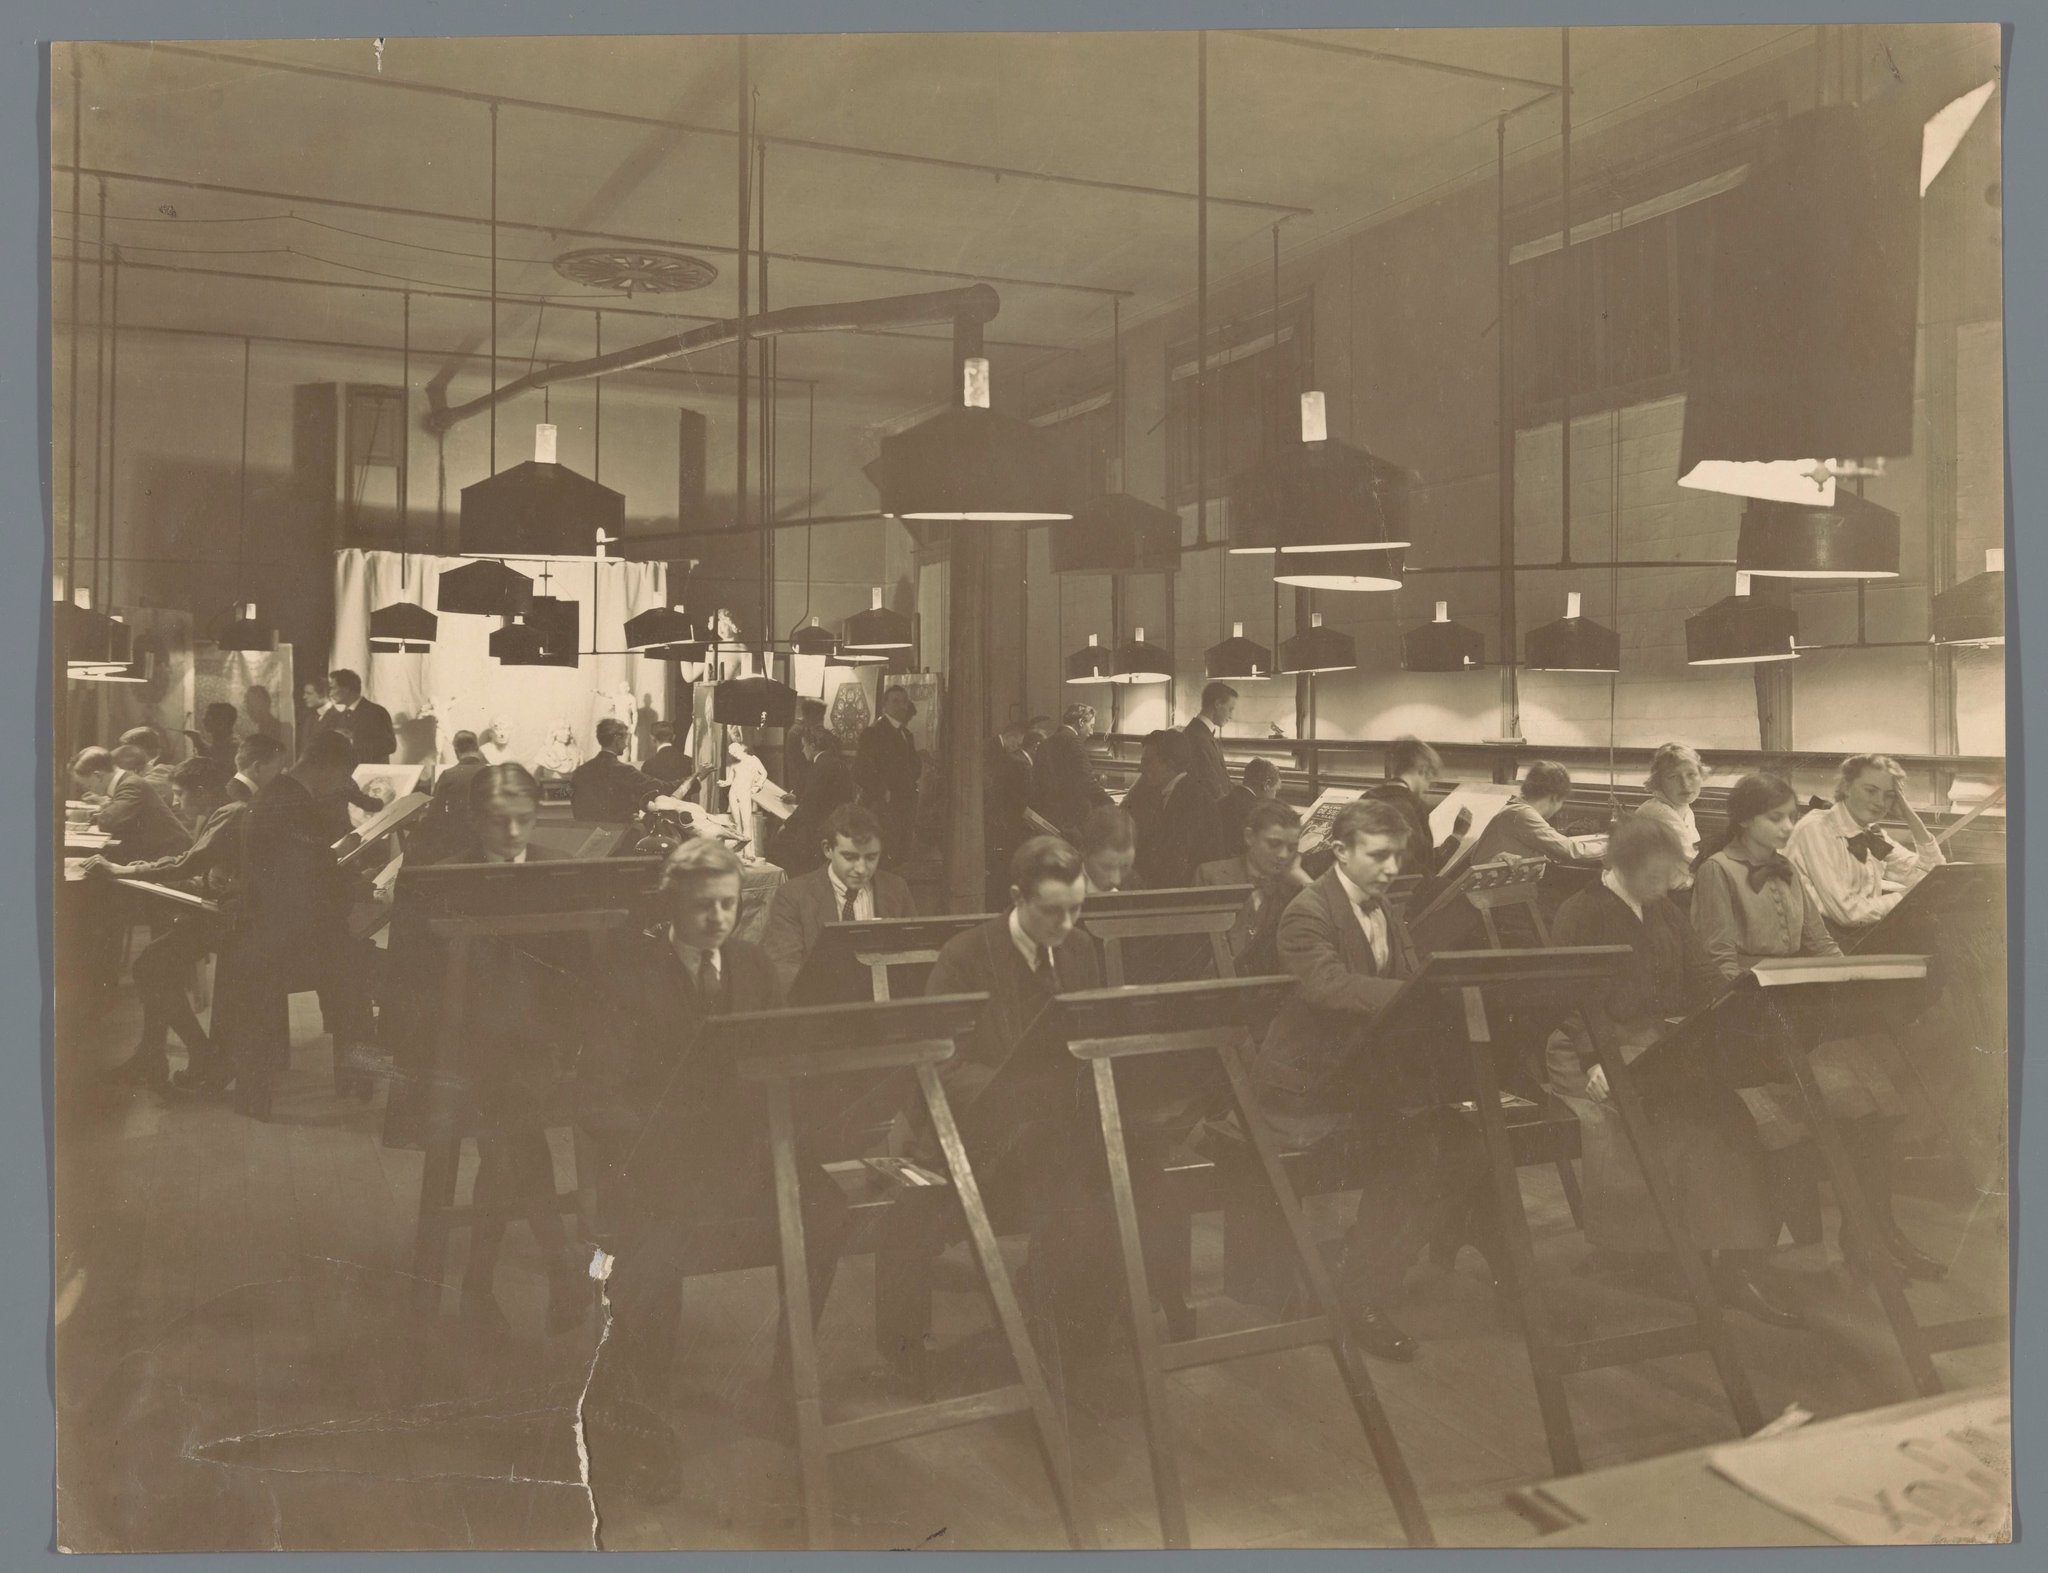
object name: photograph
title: Leerlingen in een lokaal van een kunstnijverheidsschool in Amsterdam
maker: Anonymous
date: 1919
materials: photographic support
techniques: gelatin silver print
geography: amsterdam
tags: drawing-lesson, student, amsterdam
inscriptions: inscription: ‘+- 1919’